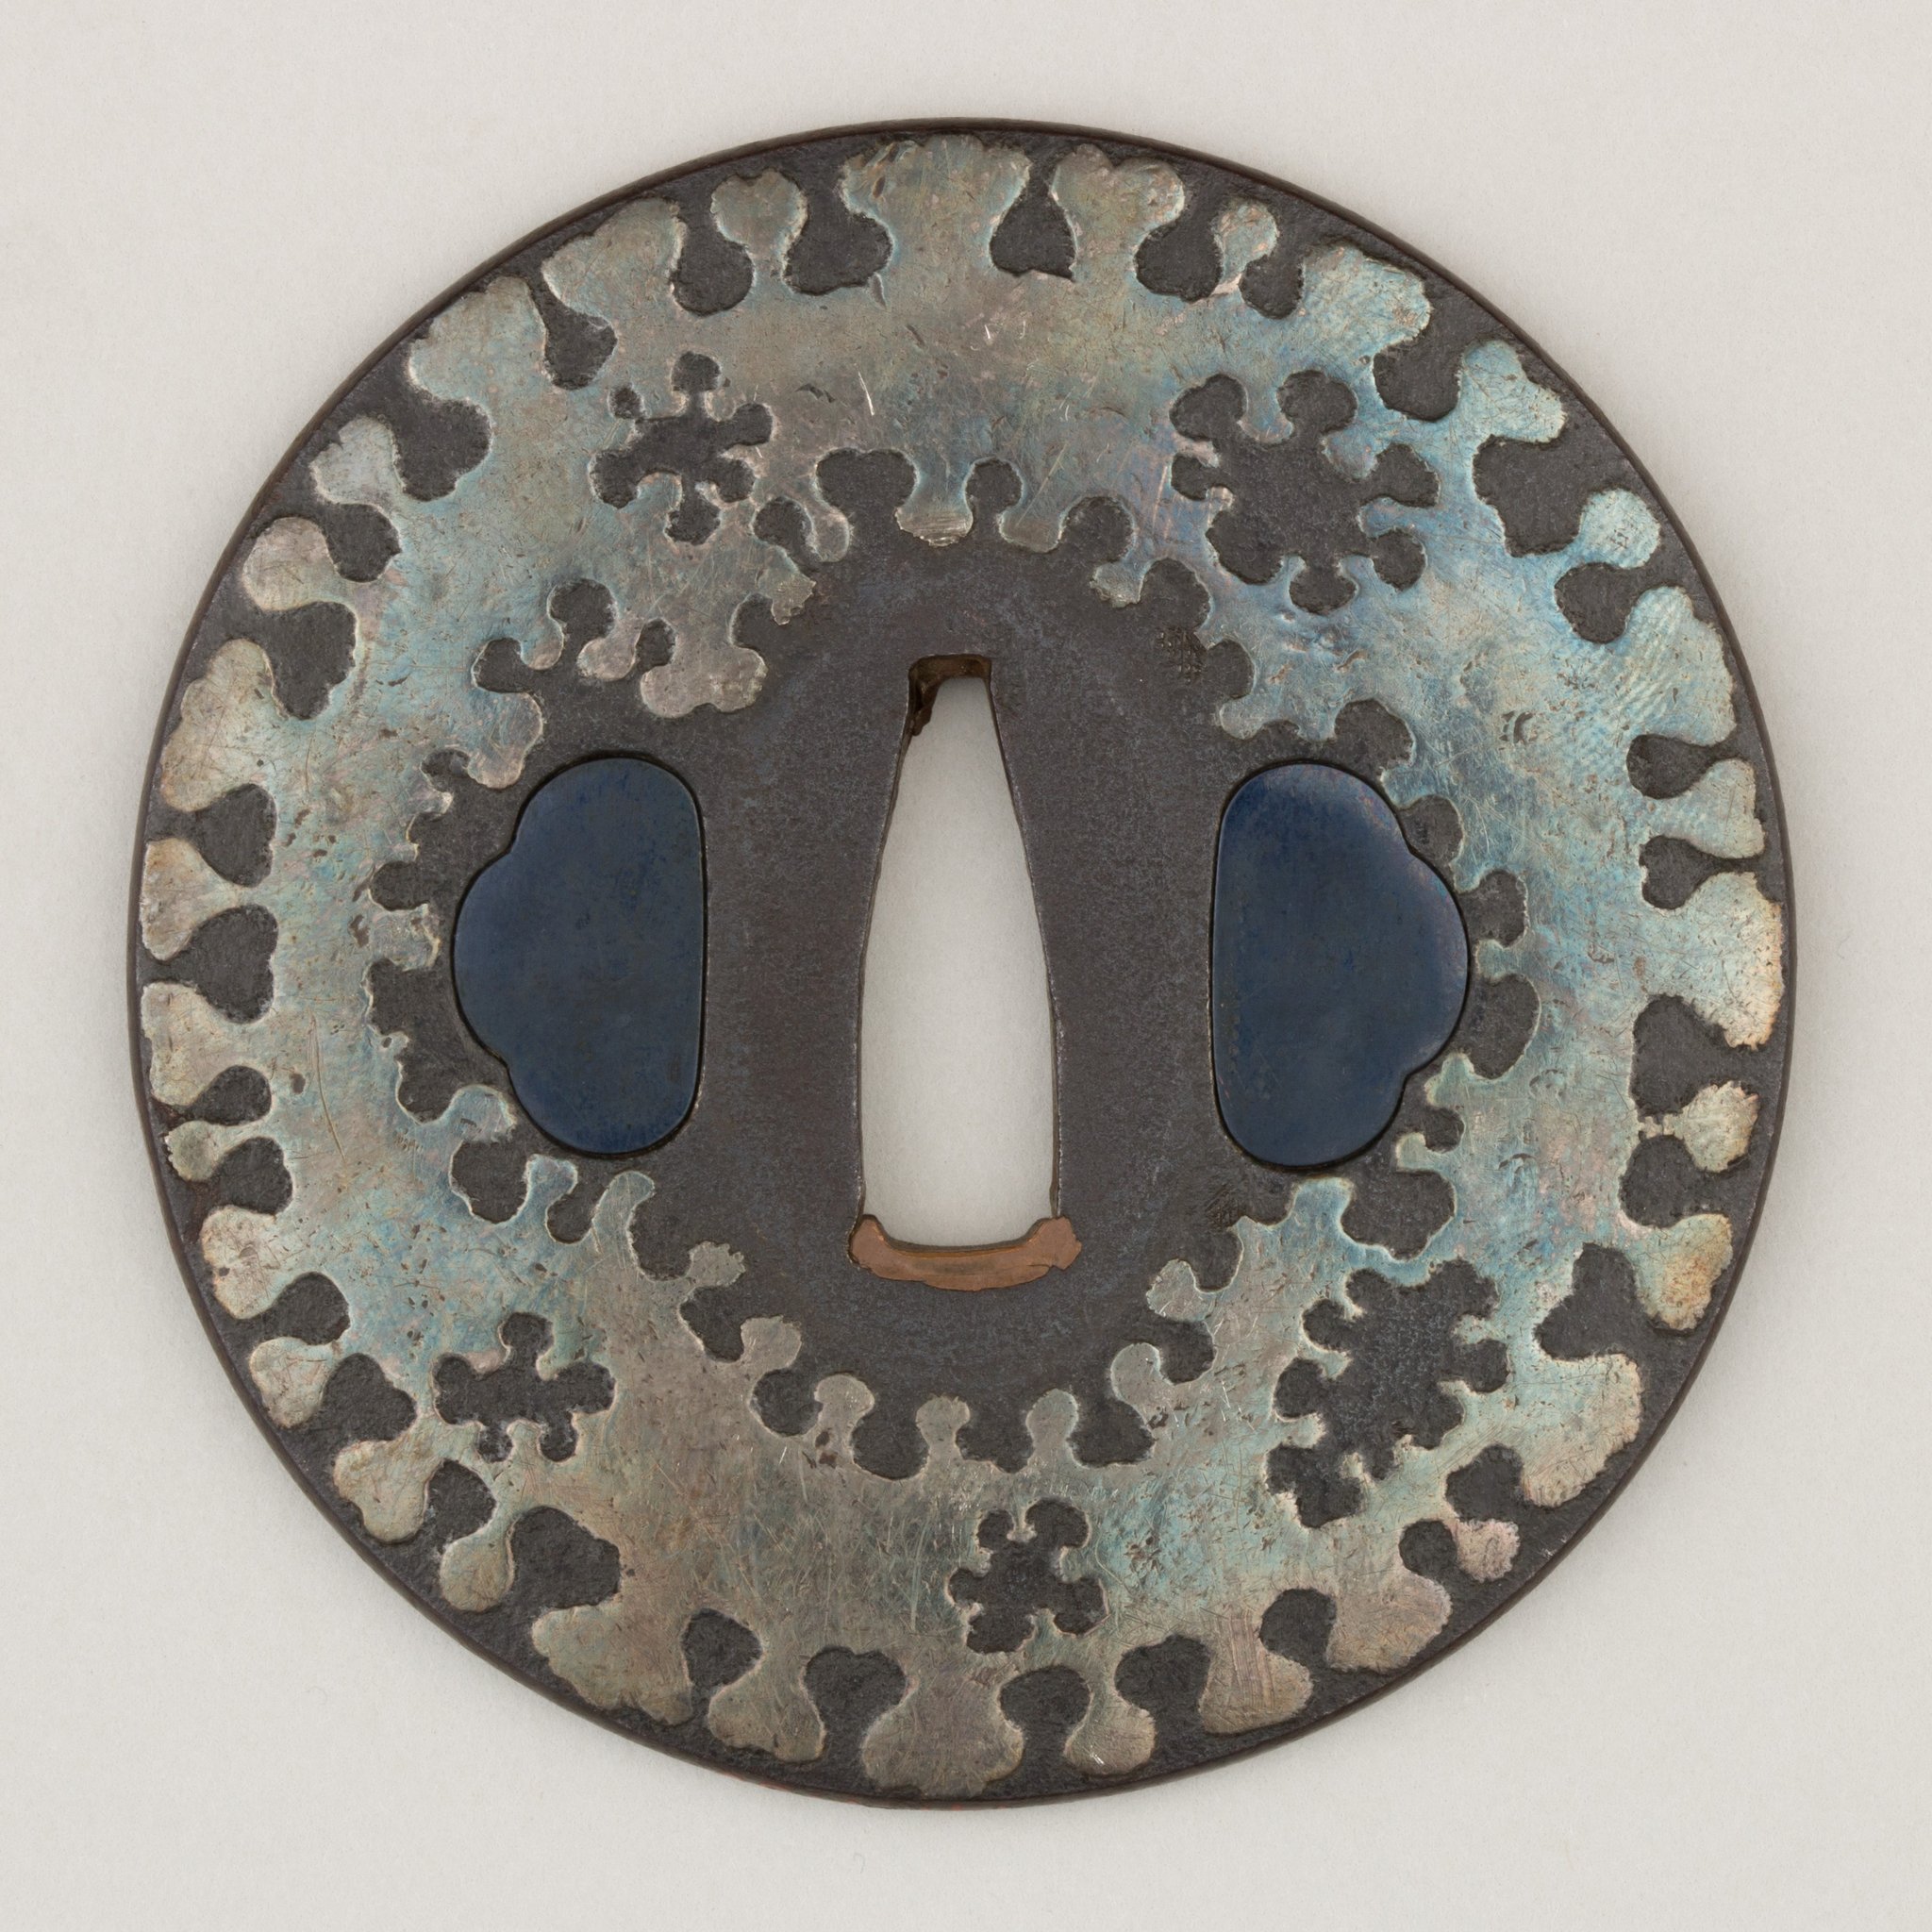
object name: sword guard tsuba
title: Sword Guard (Tsuba)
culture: japanese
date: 1667-1700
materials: copper, iron, silver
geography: japan